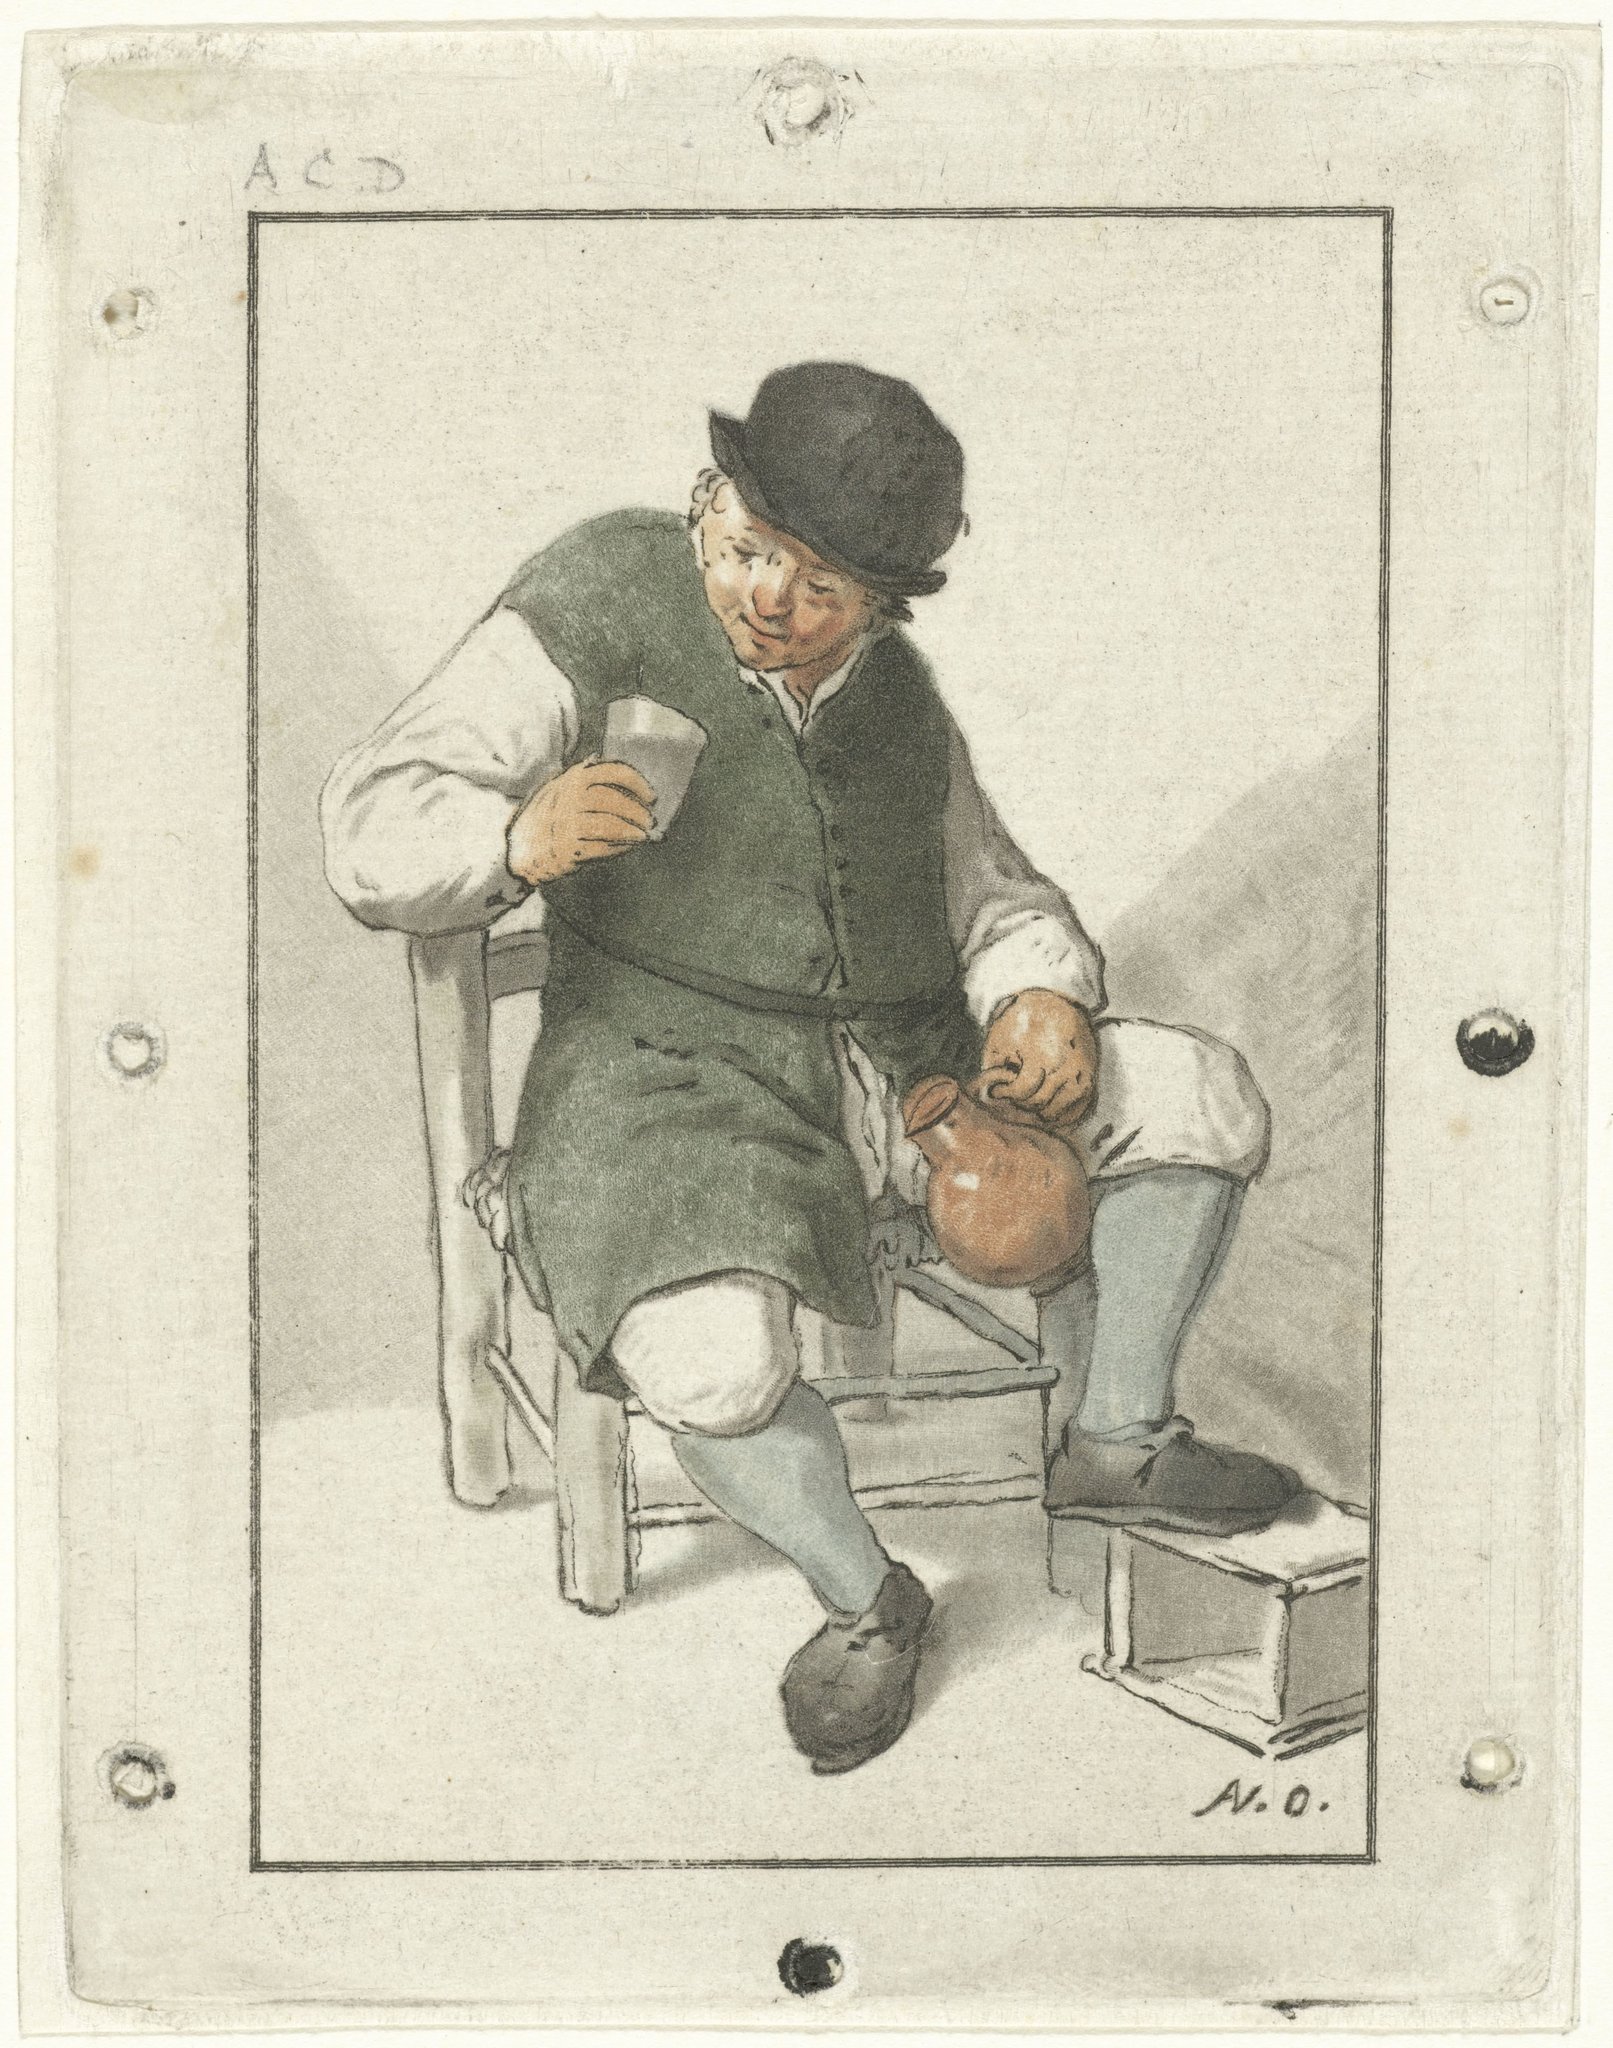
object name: print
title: Zittende boer met kruik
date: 1763-1768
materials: paper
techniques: etching, roulette, lithography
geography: amsterdam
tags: sitting figure, jar, jug (used as drinking-vessel)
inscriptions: collector's mark: Lugt 2228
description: Voor deze prenttekening, 'Zittende boer met kruik', maakte Ploos van Amstel vier verschillende platen (A, B, C, en D). Er bestaan afdrukken van één, twee, drie of alle vier de platen in alle mogelijke combinaties. Zie gerelateerde objecten voor de hier gebruikte platen.